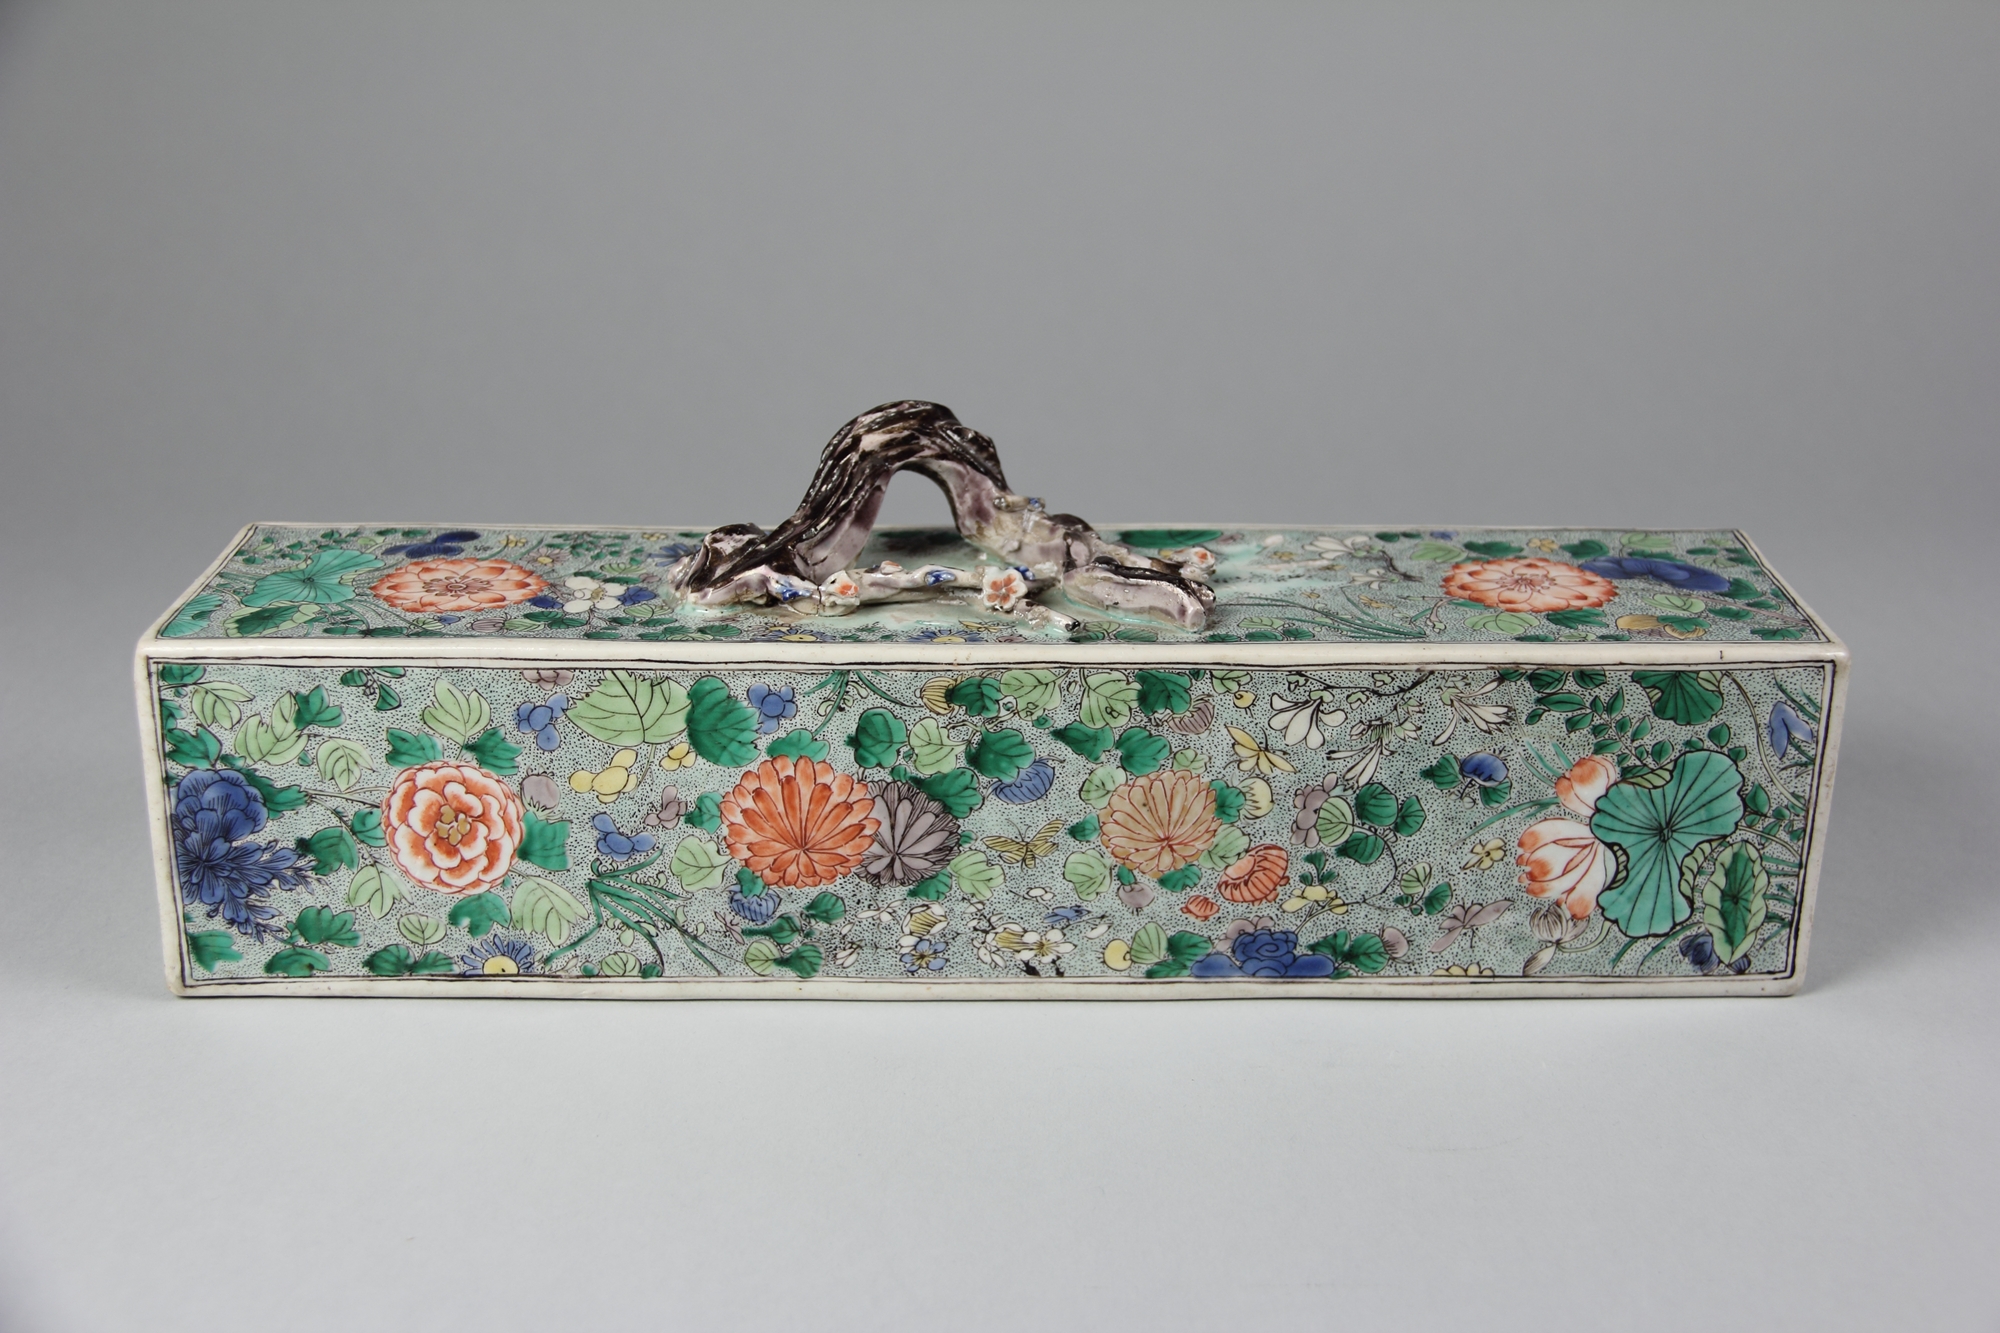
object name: box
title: Box for Perfume (?)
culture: chinese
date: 1662-1722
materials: enamel, porcelain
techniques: painting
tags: flowers,leaves